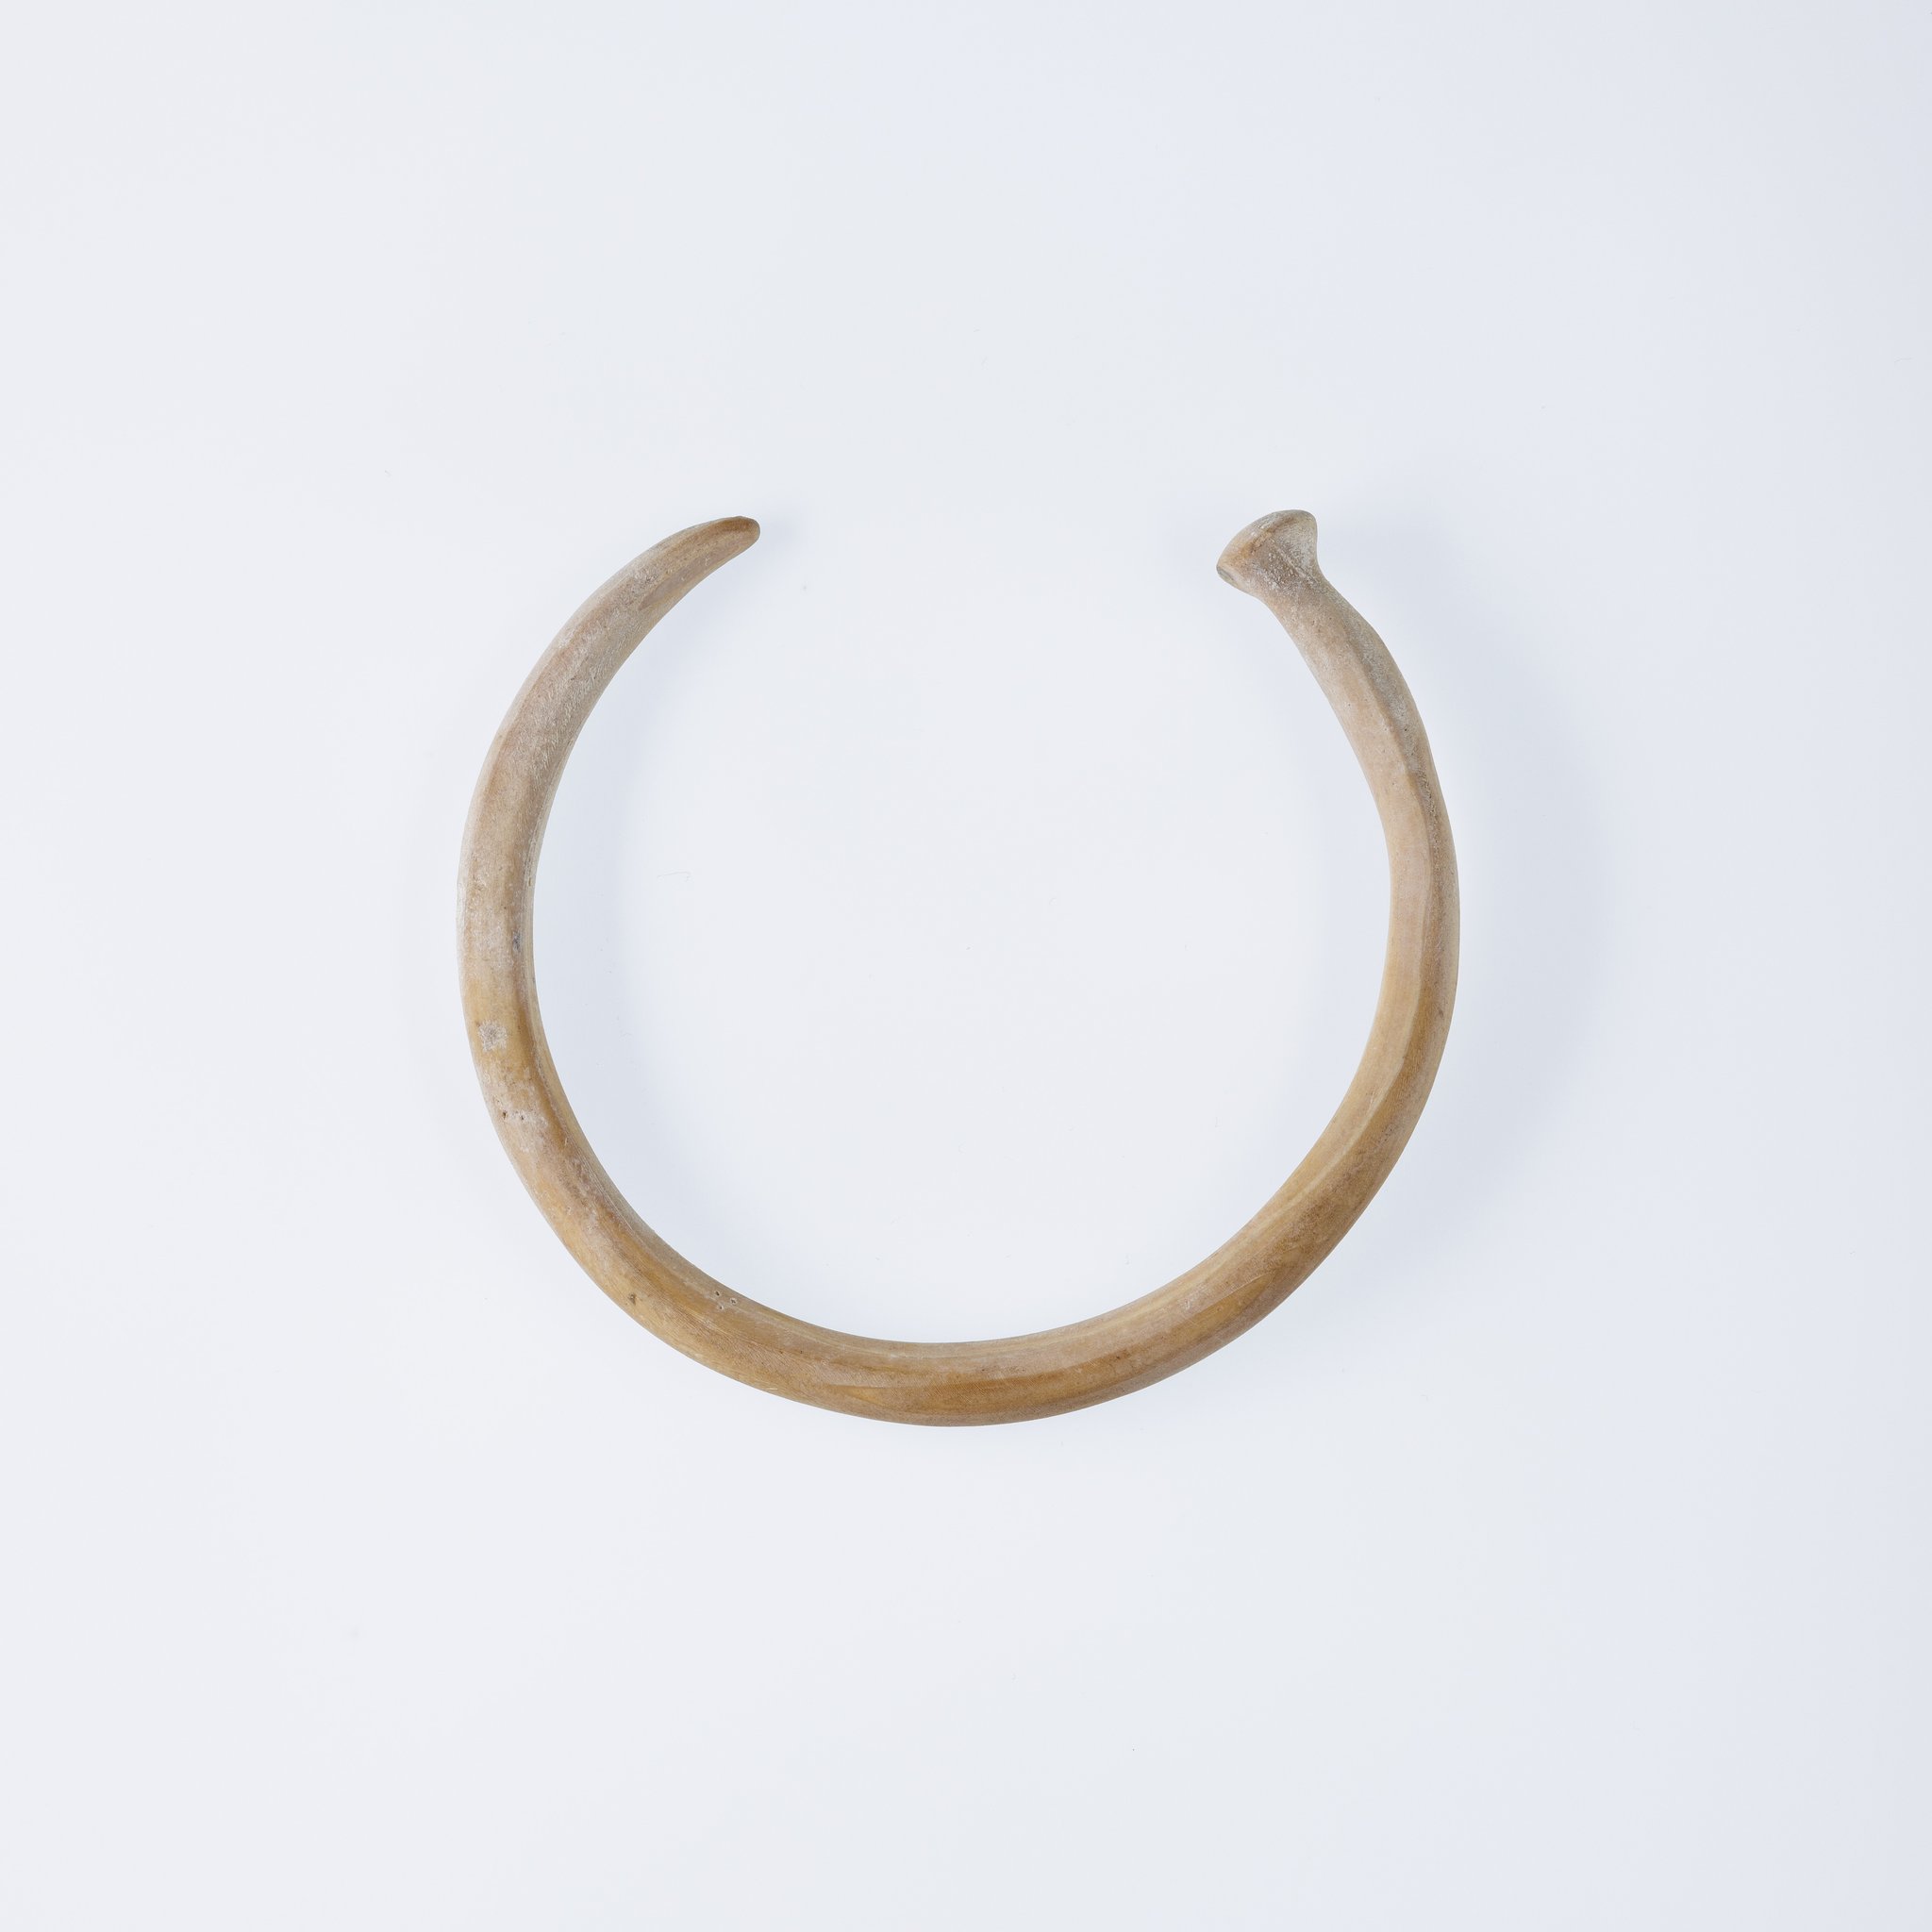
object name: bracelet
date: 4500-4000 BCE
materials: shell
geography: egypt